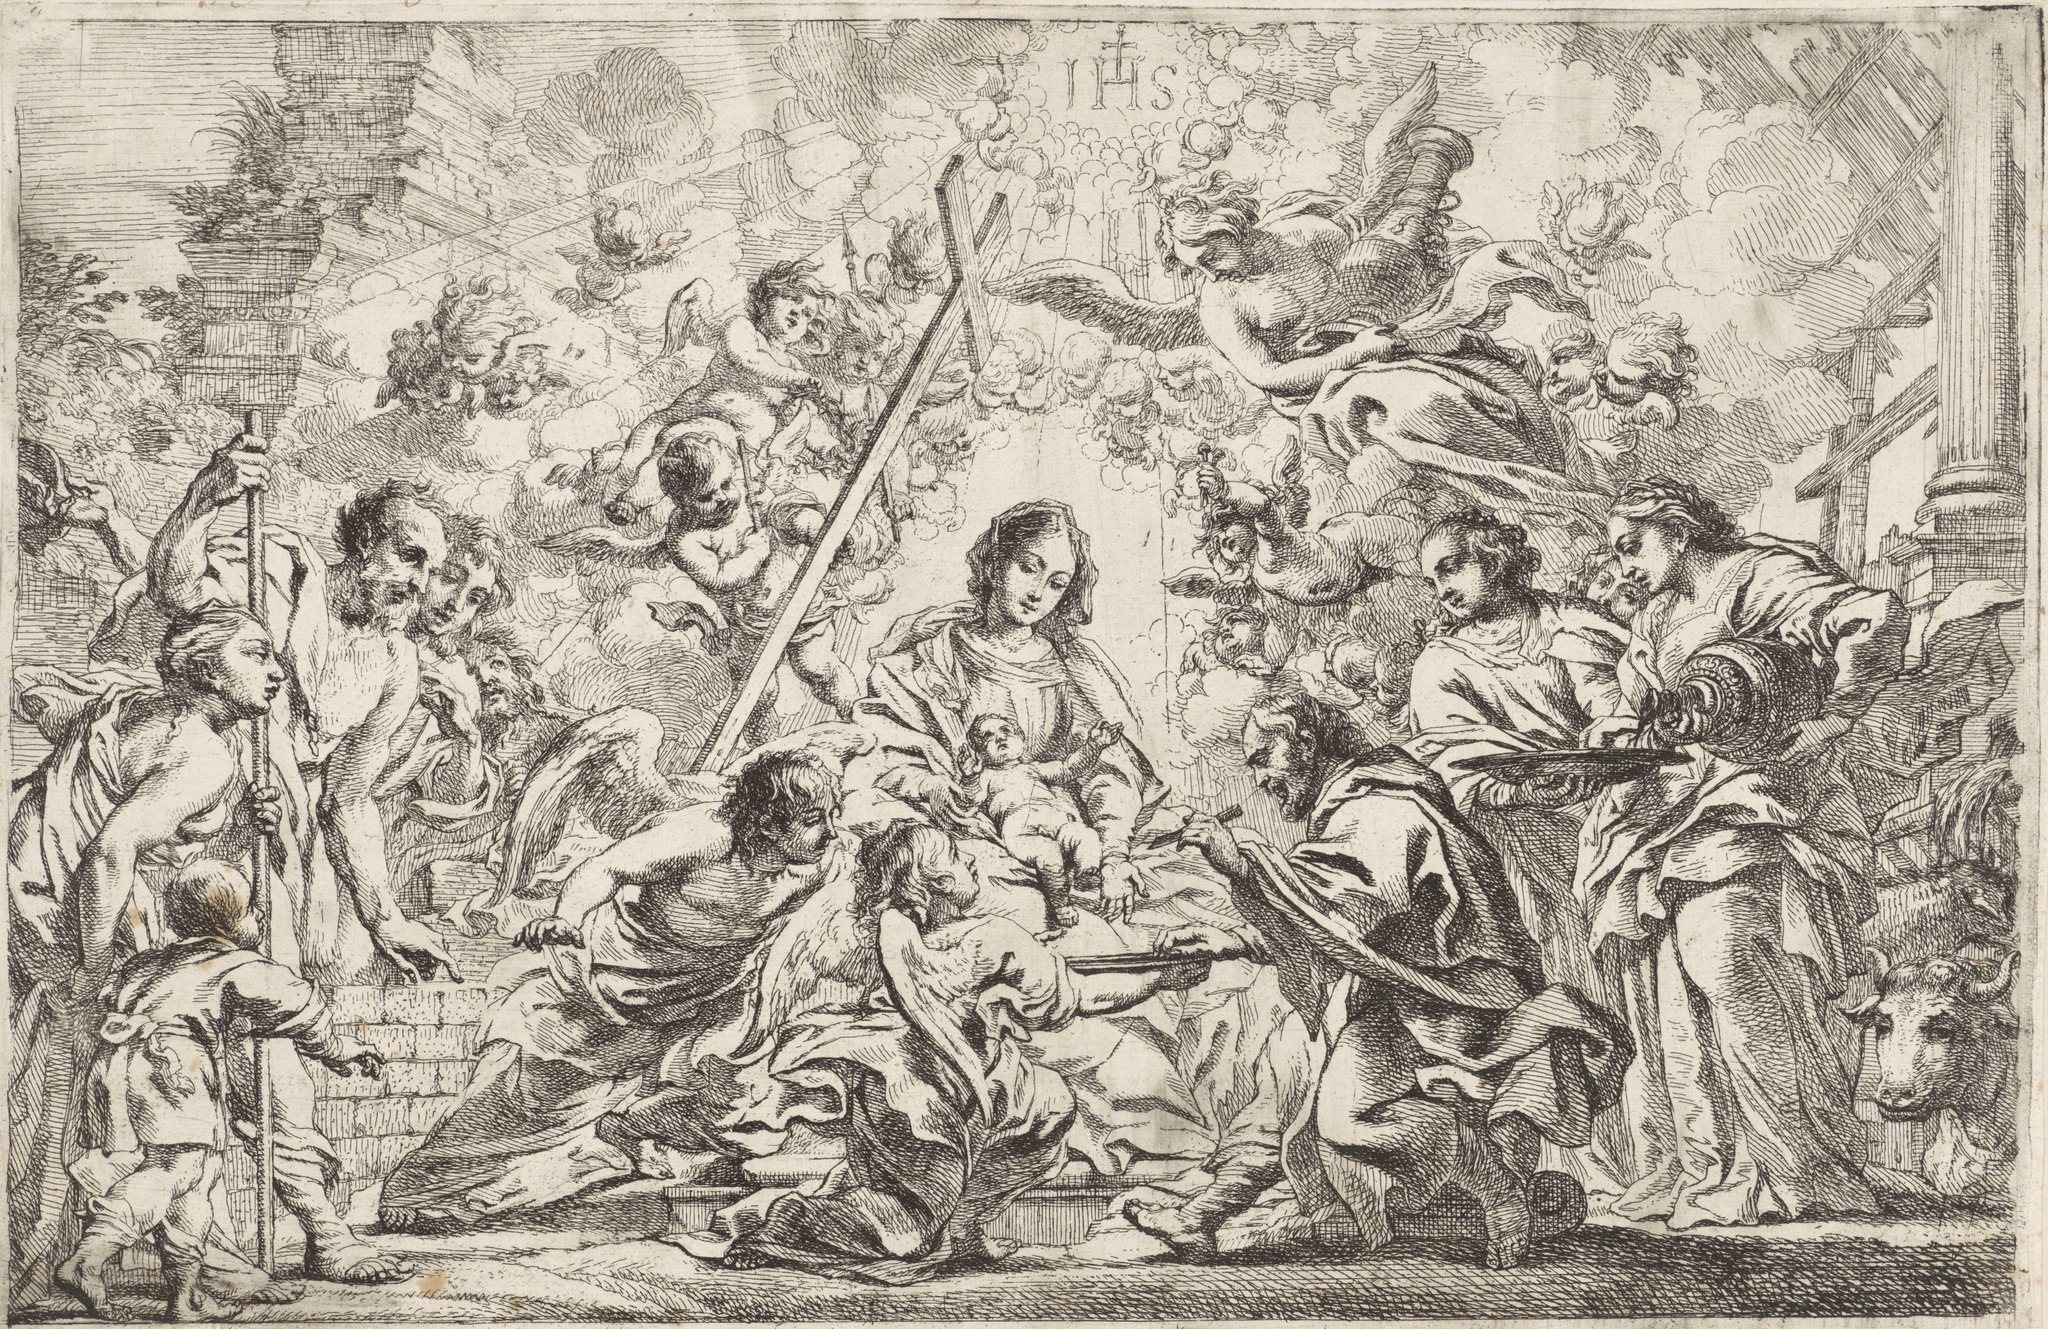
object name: print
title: Besnijdenis van Christus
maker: cornelis schut (i)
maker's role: draughtsman, print maker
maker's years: 1597-1655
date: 1618-1655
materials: paper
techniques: etching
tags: circumcision of the christ-child by the priest in the temple (luke 2:21)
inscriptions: collector's mark: Lugt 240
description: Het Christuskind ligt bij Maria op schoot. Een priester zit op een kruk voor haar en pakt een mes op van een schaal die een engel hem voorhoudt. Een tweede engel daarnaast kijkt toe. Aan beide zijden staan toeschouwers. rechts liggen de os en ezel. In de lucht een engel met een kruik. Putti houden de passie-werktuigen vast.